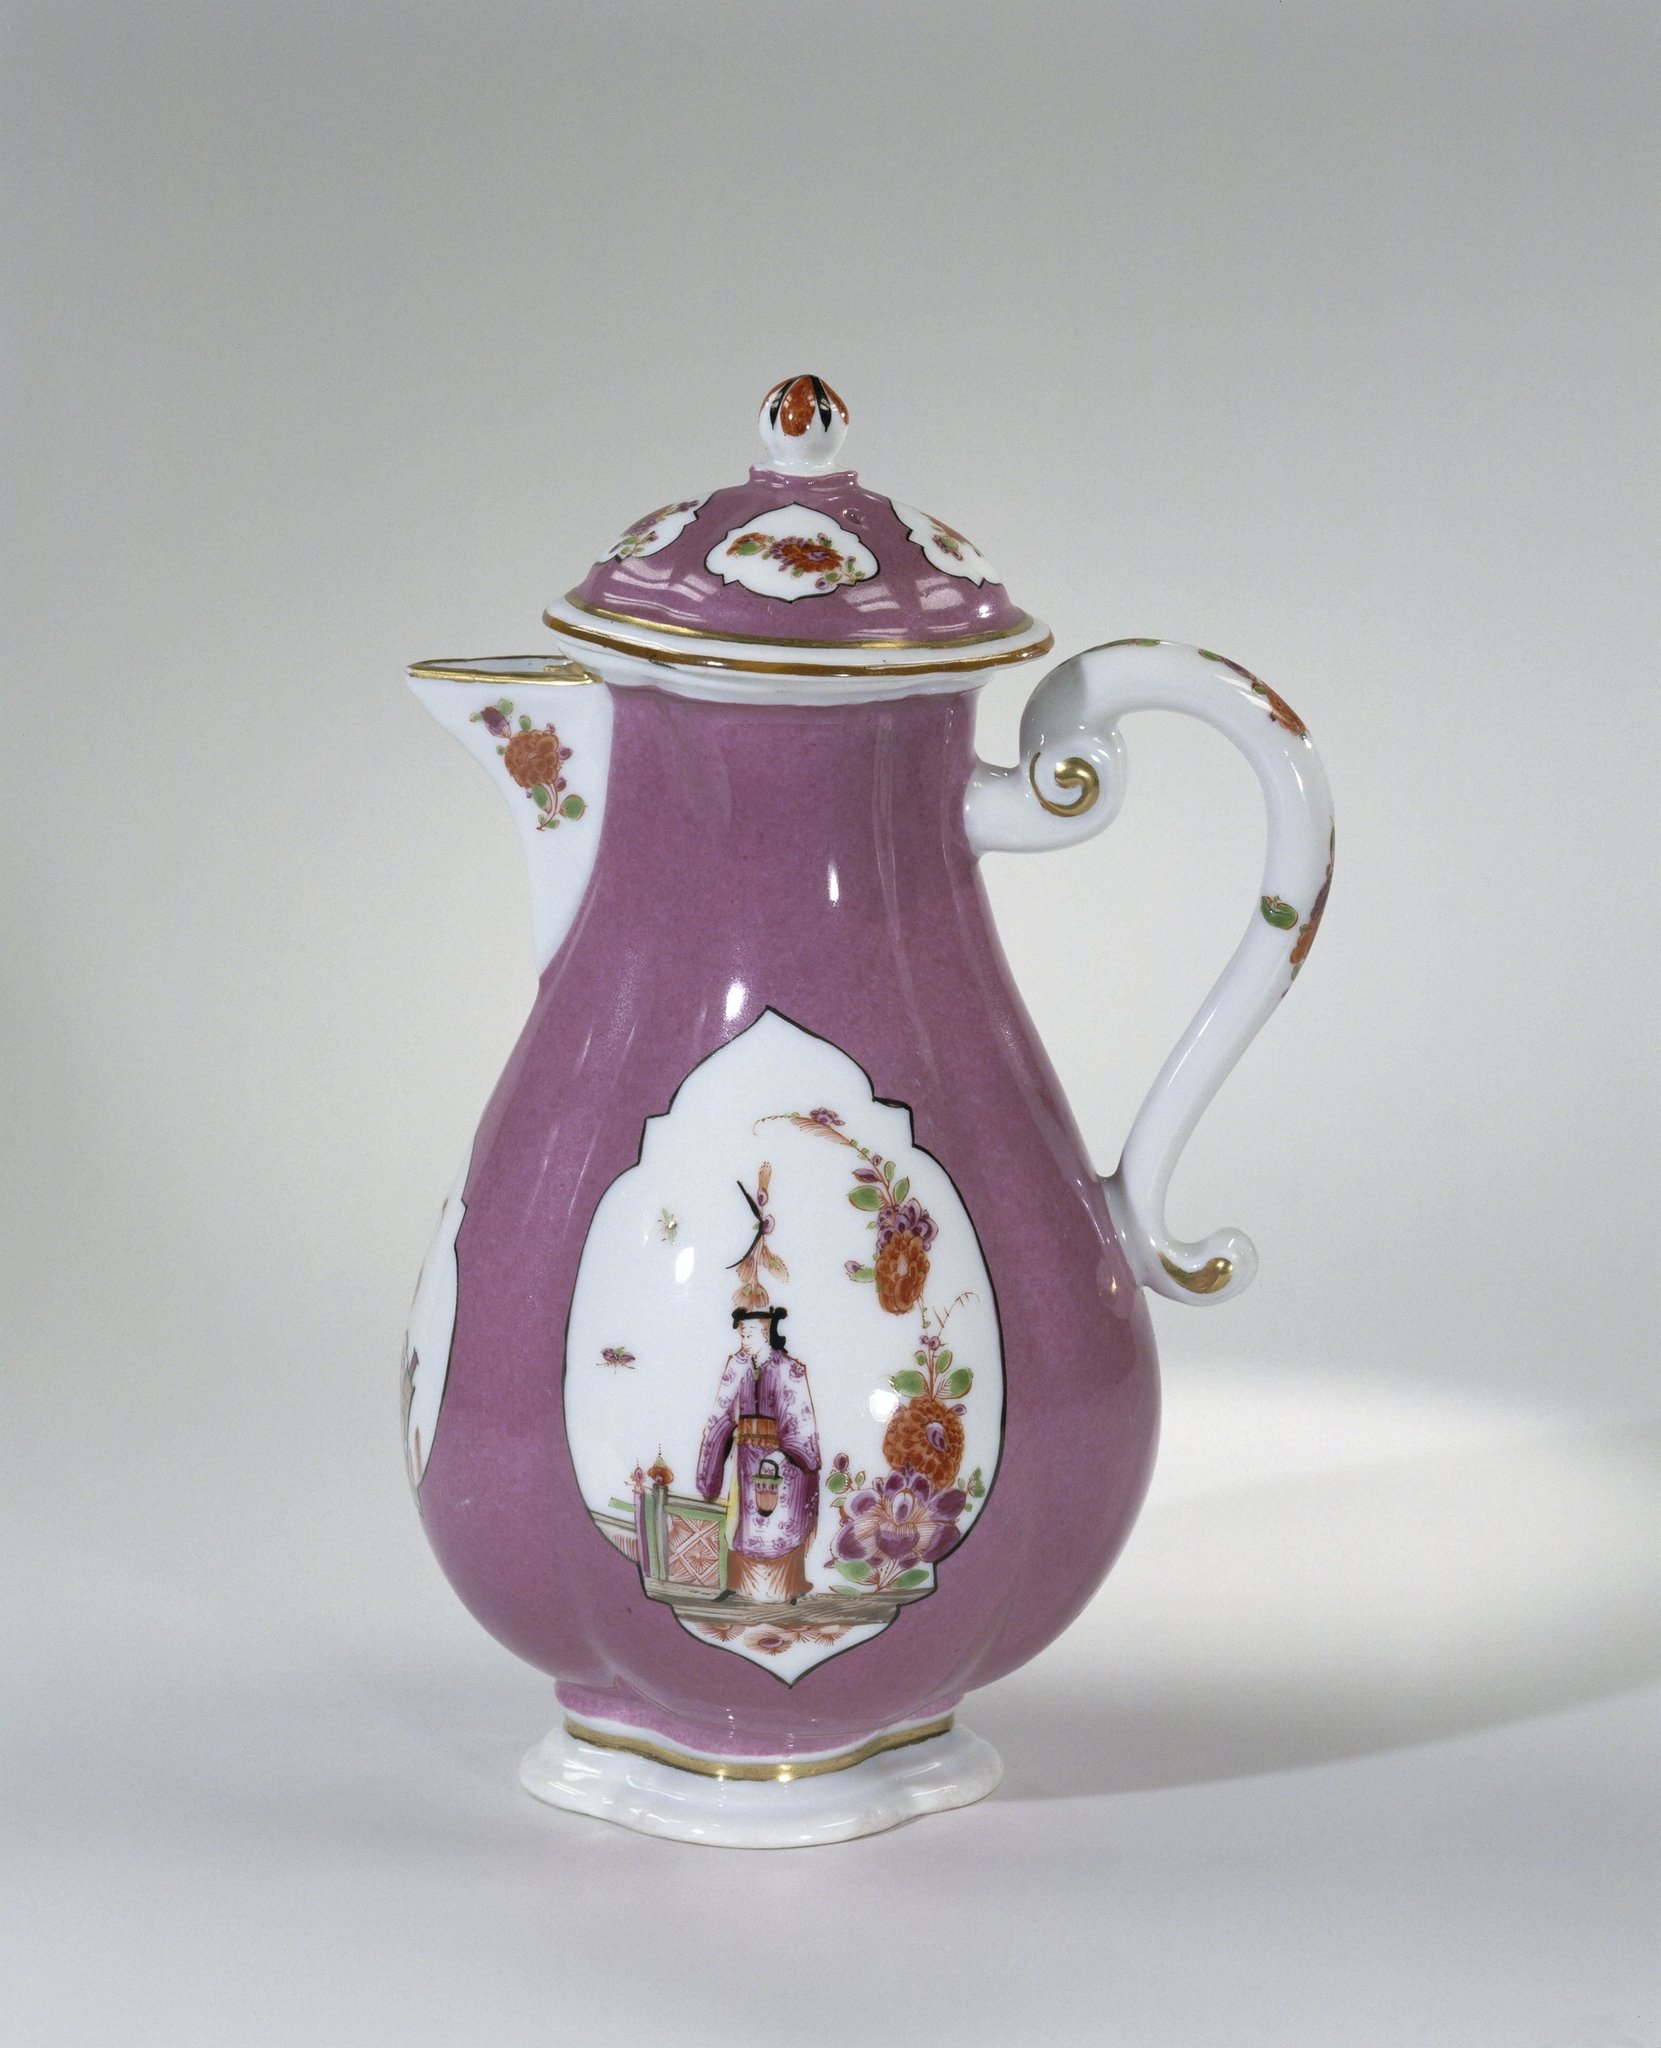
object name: eating drinking utensil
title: Deksel van koffiekan, veelkleurig beschilderd met Chinezen in uitgespaarde vierpassen in een violette fond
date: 1730-1735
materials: porcelain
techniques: painted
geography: meissen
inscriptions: factory mark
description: Deksel van beschilderd porselein. In de fond van het deksel zijn vier vierpassen uitgespaard met bloemen.